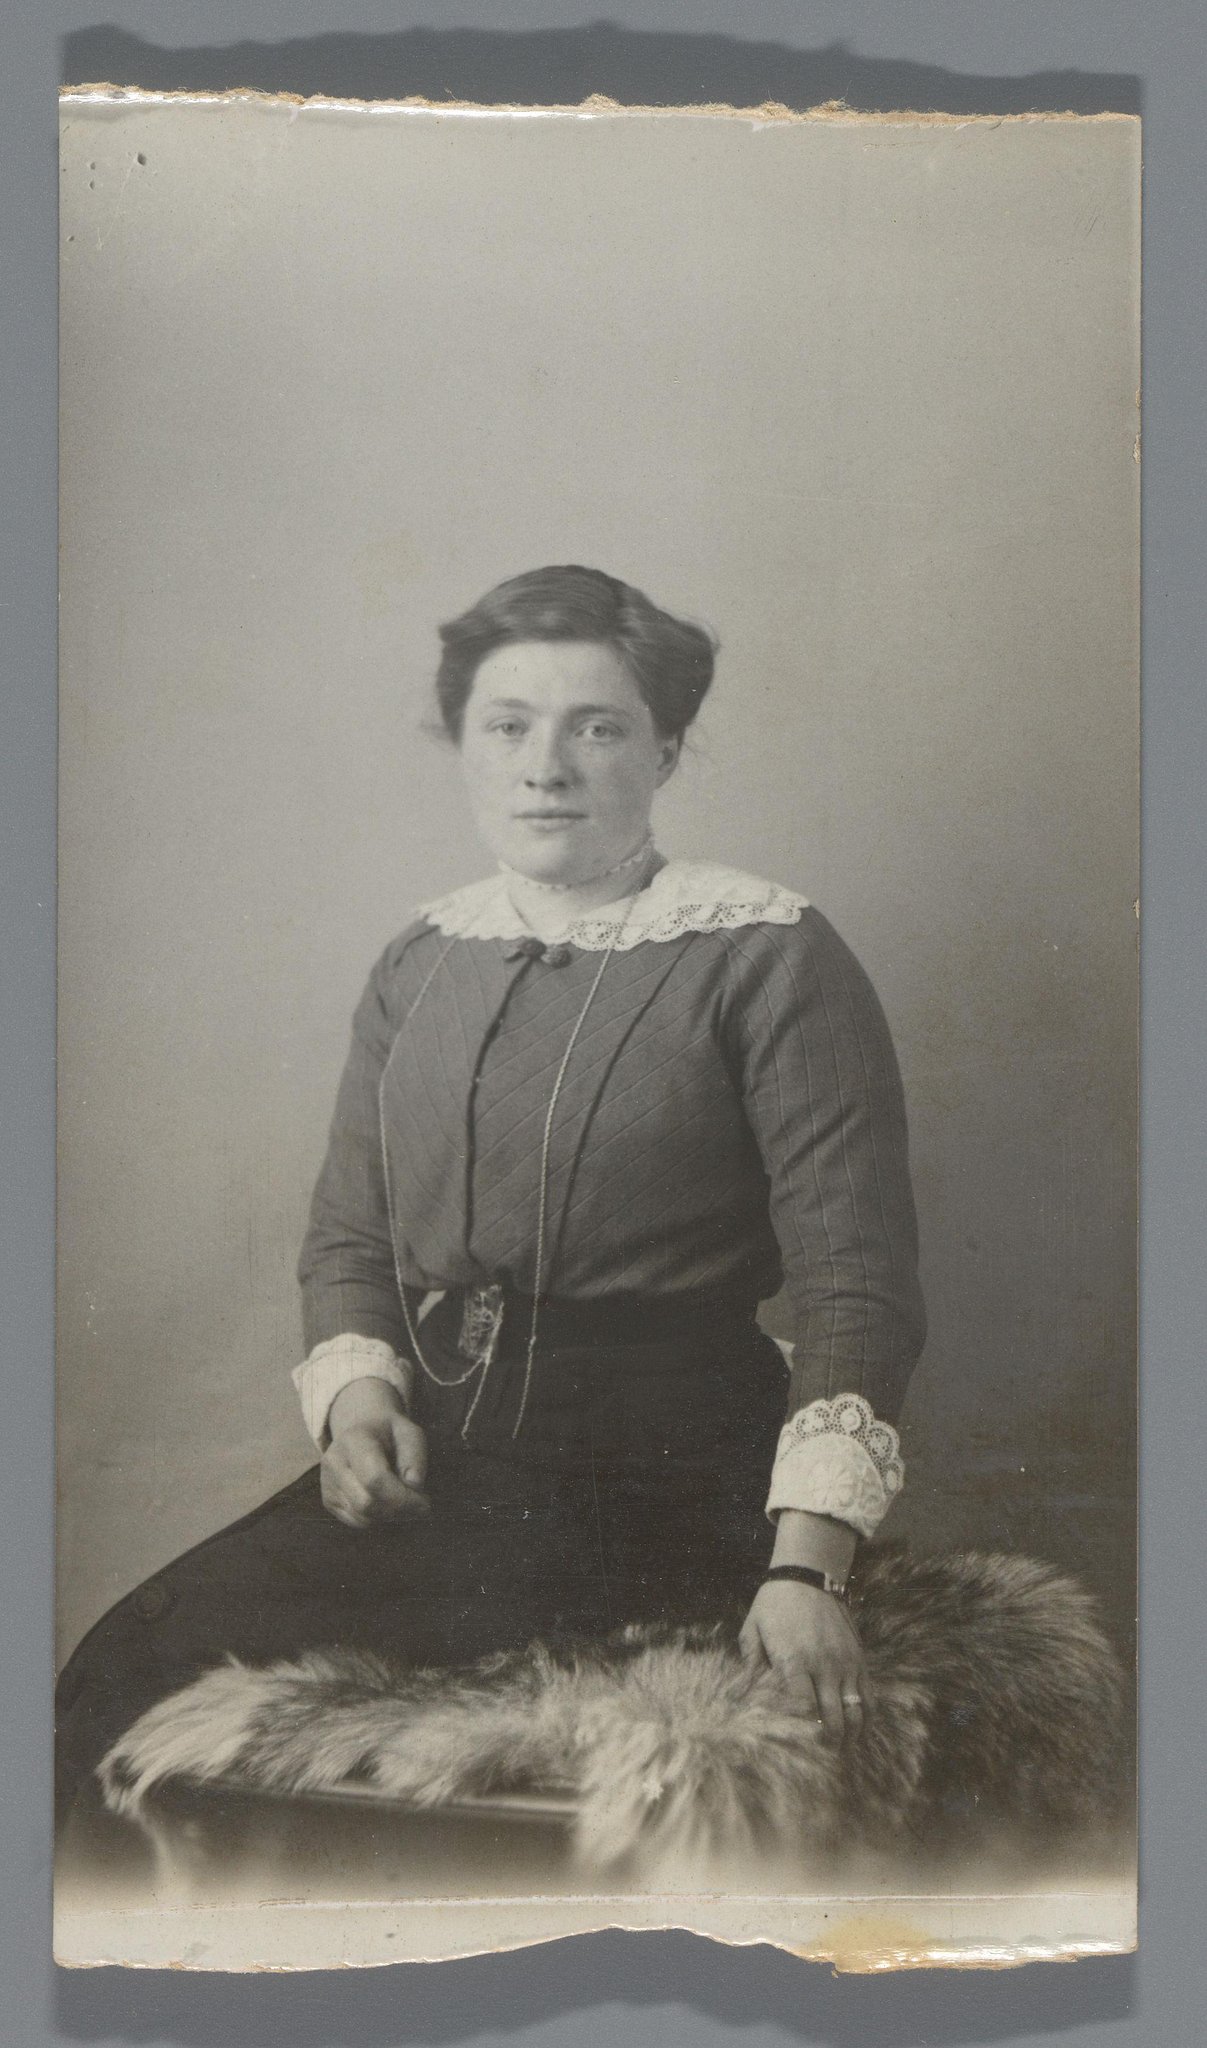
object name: snapshot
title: Portret van een vrouw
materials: photographic support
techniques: gelatin silver print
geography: groningen